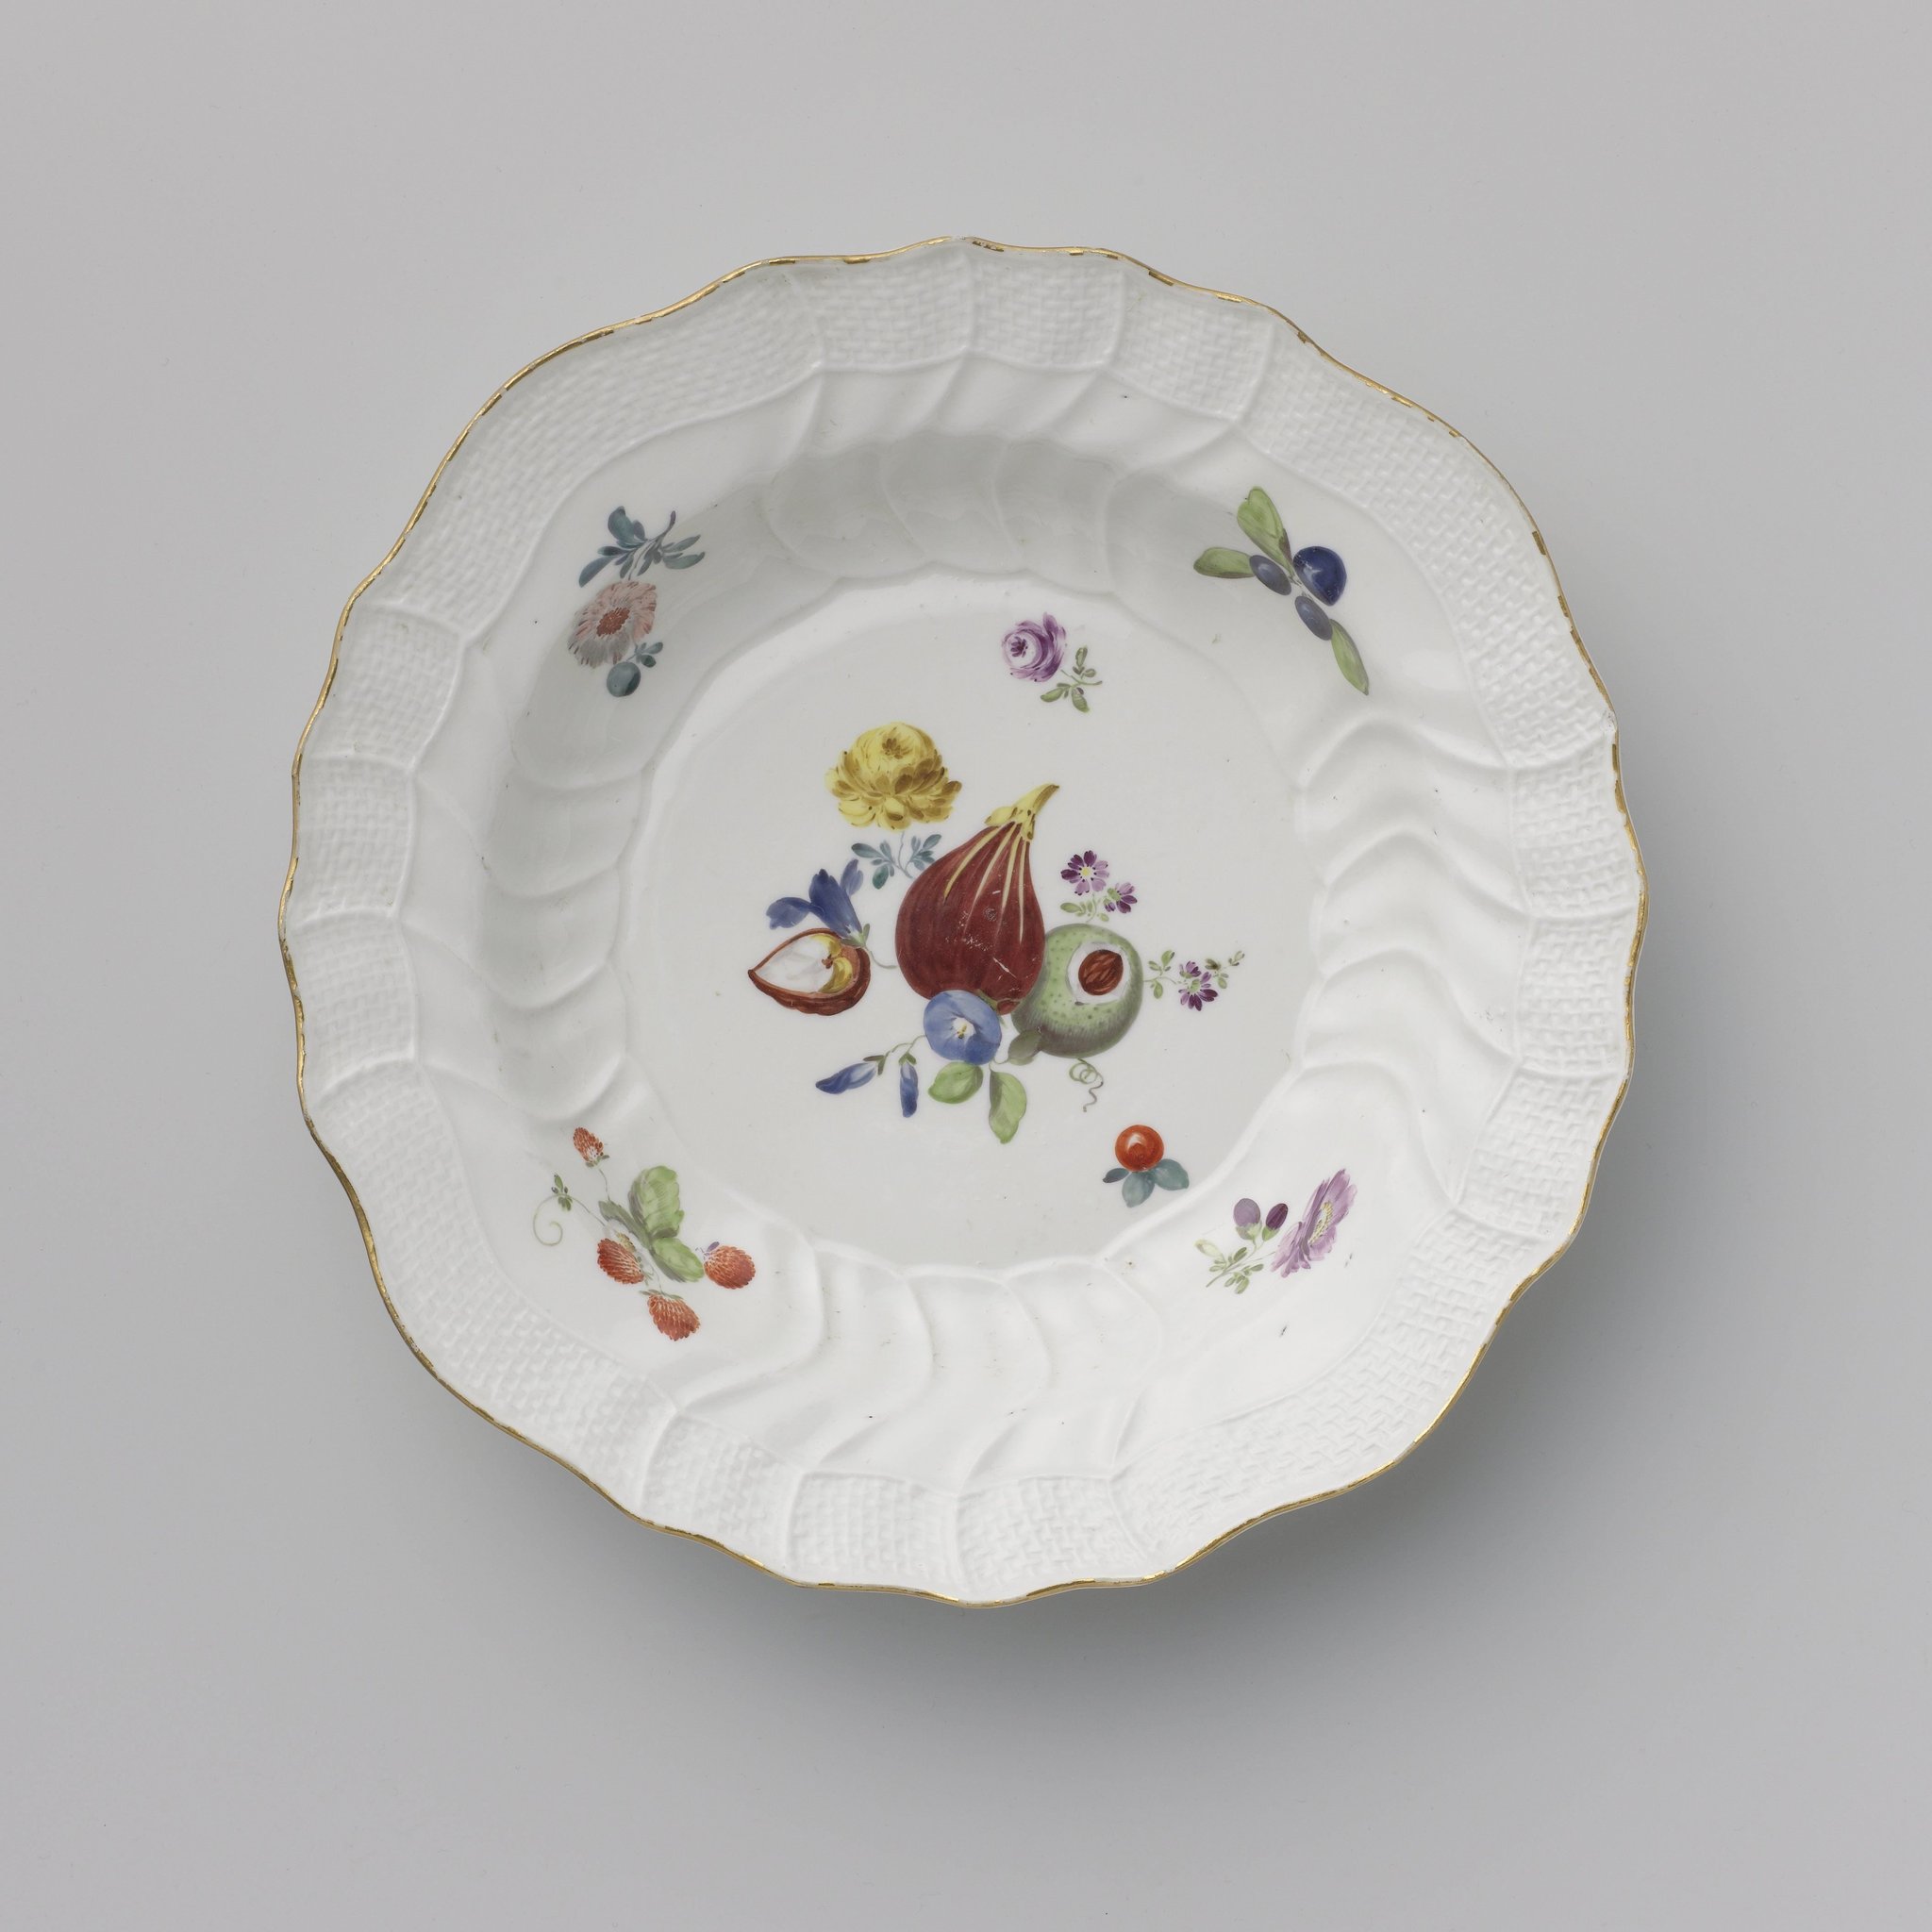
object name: plate dish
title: Bord, veelkleurig beschilderd met Deutsche Blumen, insekten en vruchten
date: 1750-1760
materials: porcelain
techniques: painted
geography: meissen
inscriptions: factory mark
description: Rond soepbord van beschilderd porselein. Het bord is beschilderd met Deutsche Blumen, insekten en vruchten. De rand is in reliëf versierd met het Neuozier-patroon. Het bord is gemerkt en hoort bij een servies (BK-17474-1 t/m BK-17474-253).